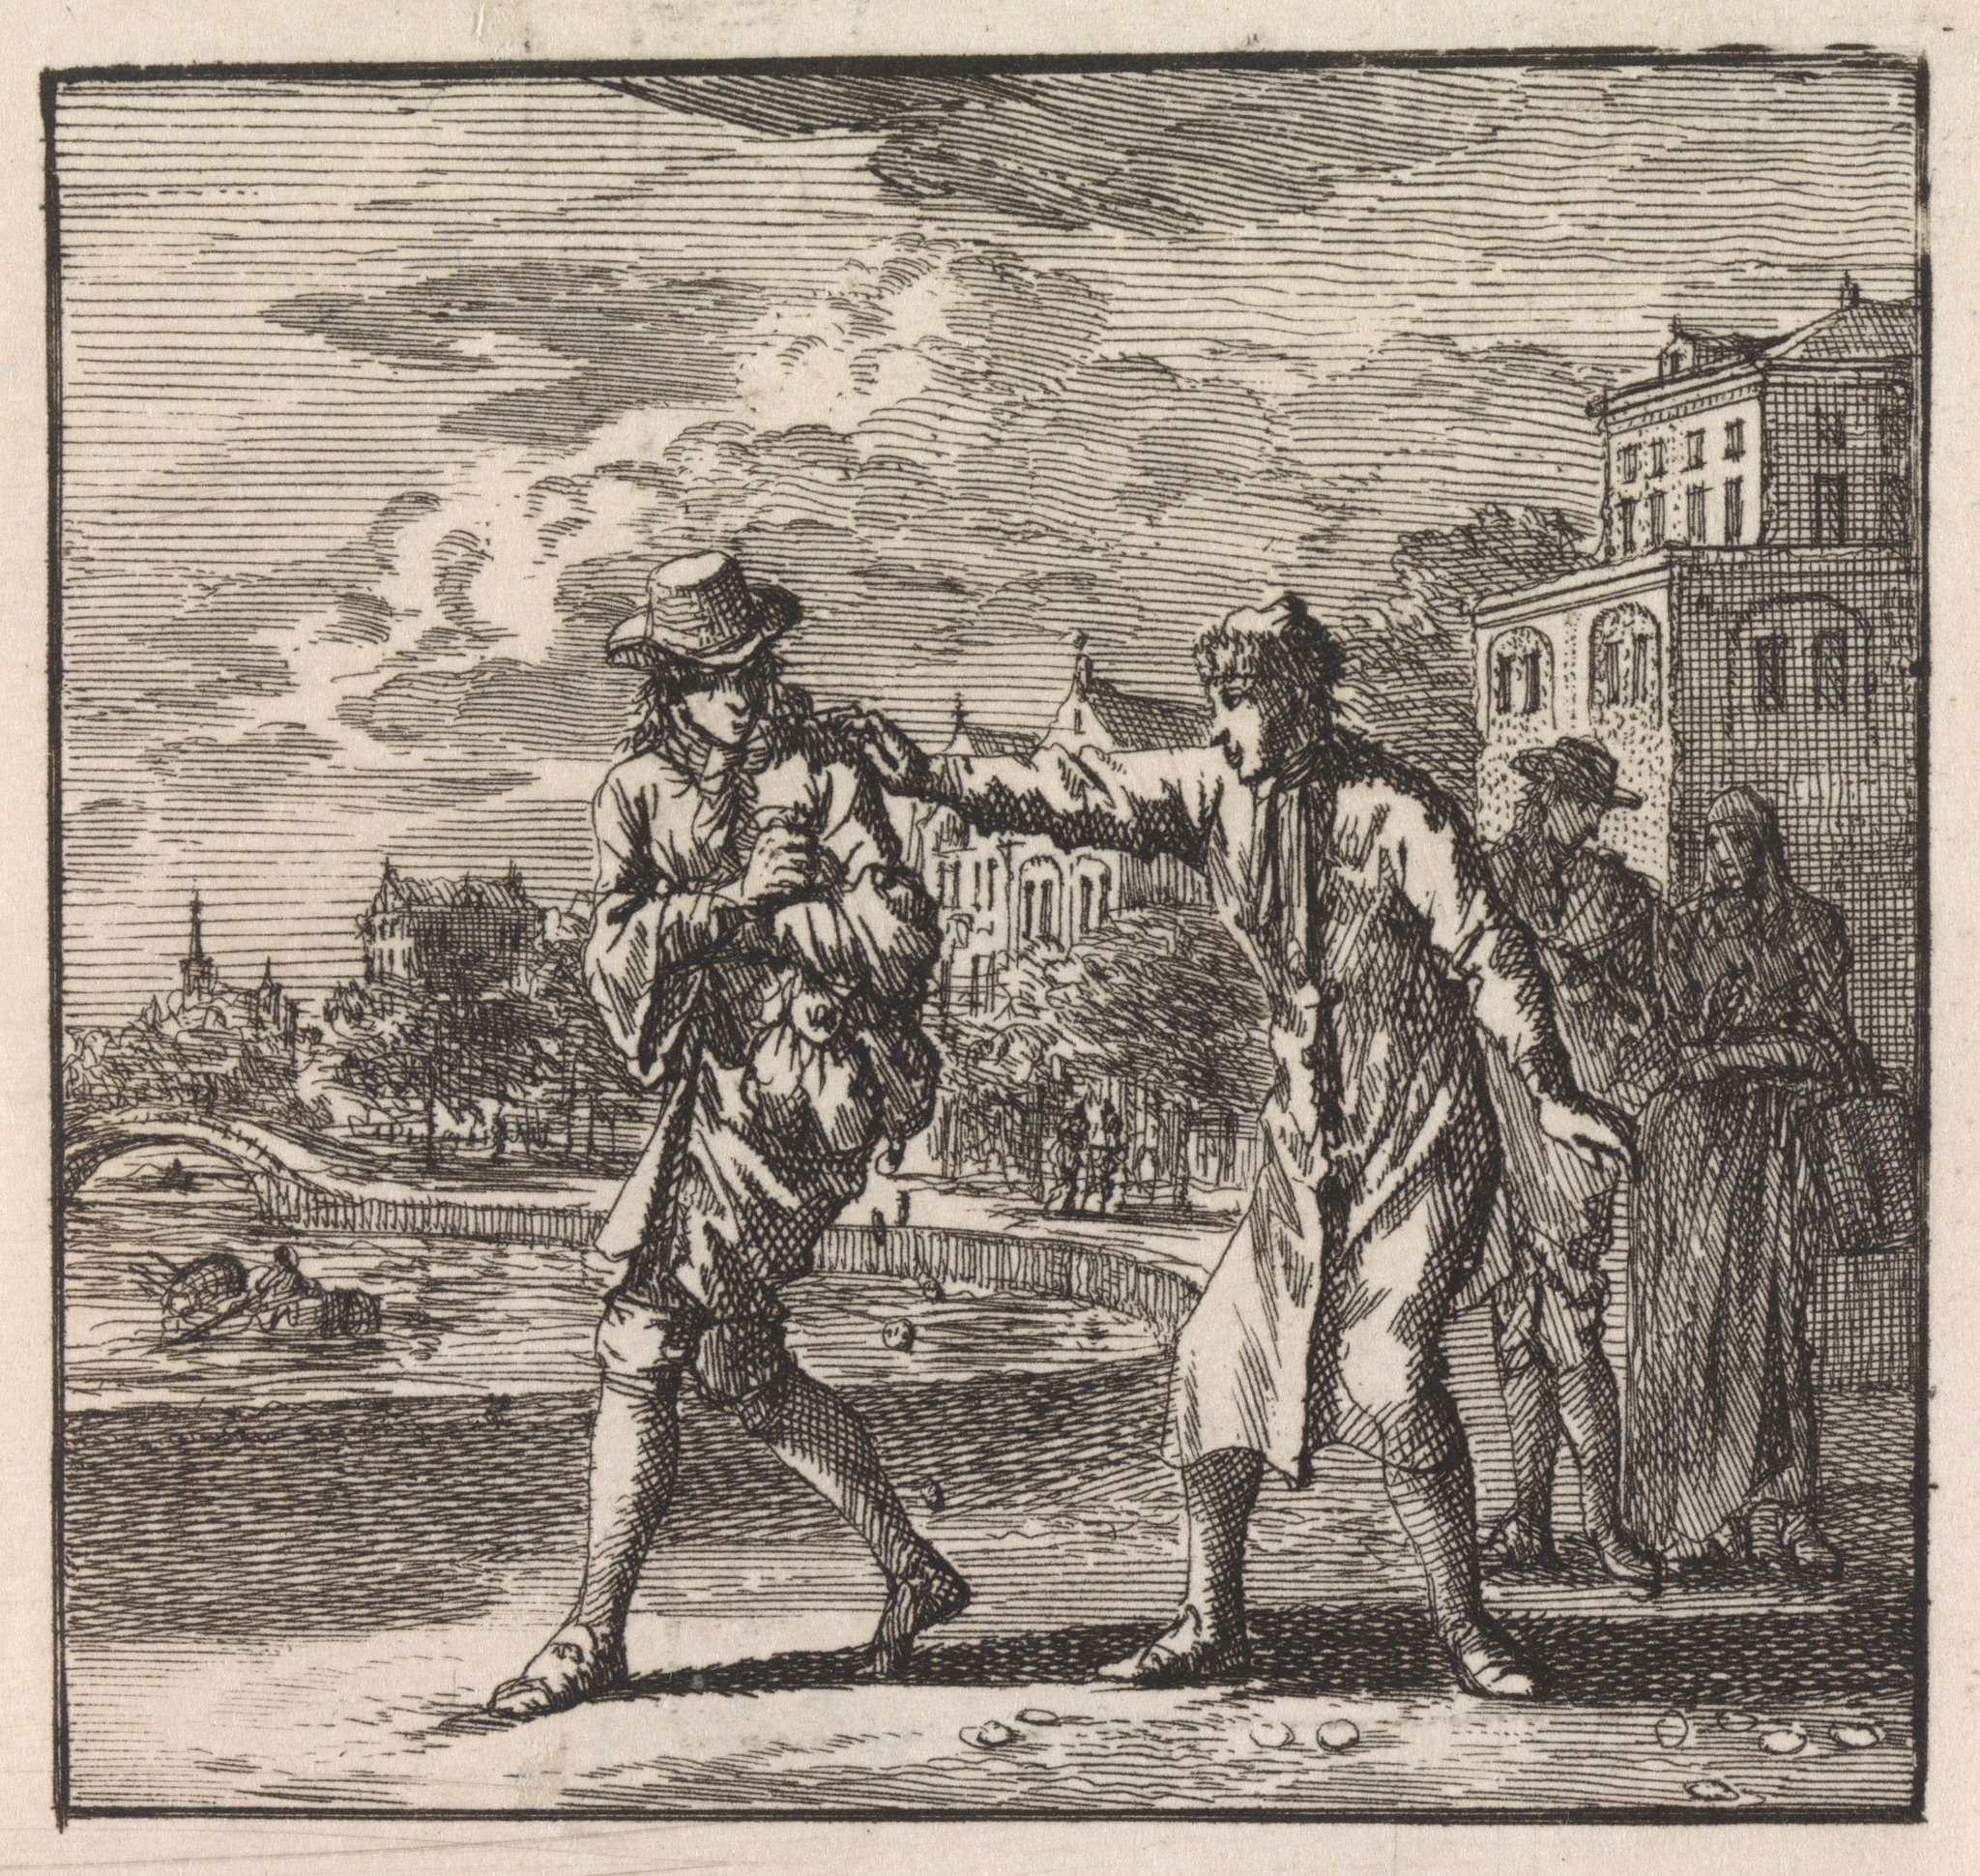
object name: print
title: De Onvoorzichtige Voorzichtigheid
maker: jan luyken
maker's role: draughtsman, print maker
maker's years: 1649-1712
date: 1710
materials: paper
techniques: etching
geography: amsterdam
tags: attention, concentration (+ situation or event (especially in genre-painting) with symbolical connotation), purse, money-bag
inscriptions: collector's mark: Lugt 2228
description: Proefdruk voor illustratie uit: Luyken, Jan. De onwaardige wereld, vertoond in vyftig zinnebeelden, met godlyke spreuken en stichtelyke verzen. Amsterdam: Pieter Arentsz. II (wed.) en Cornelis van der Sys, 1710, p. 108.